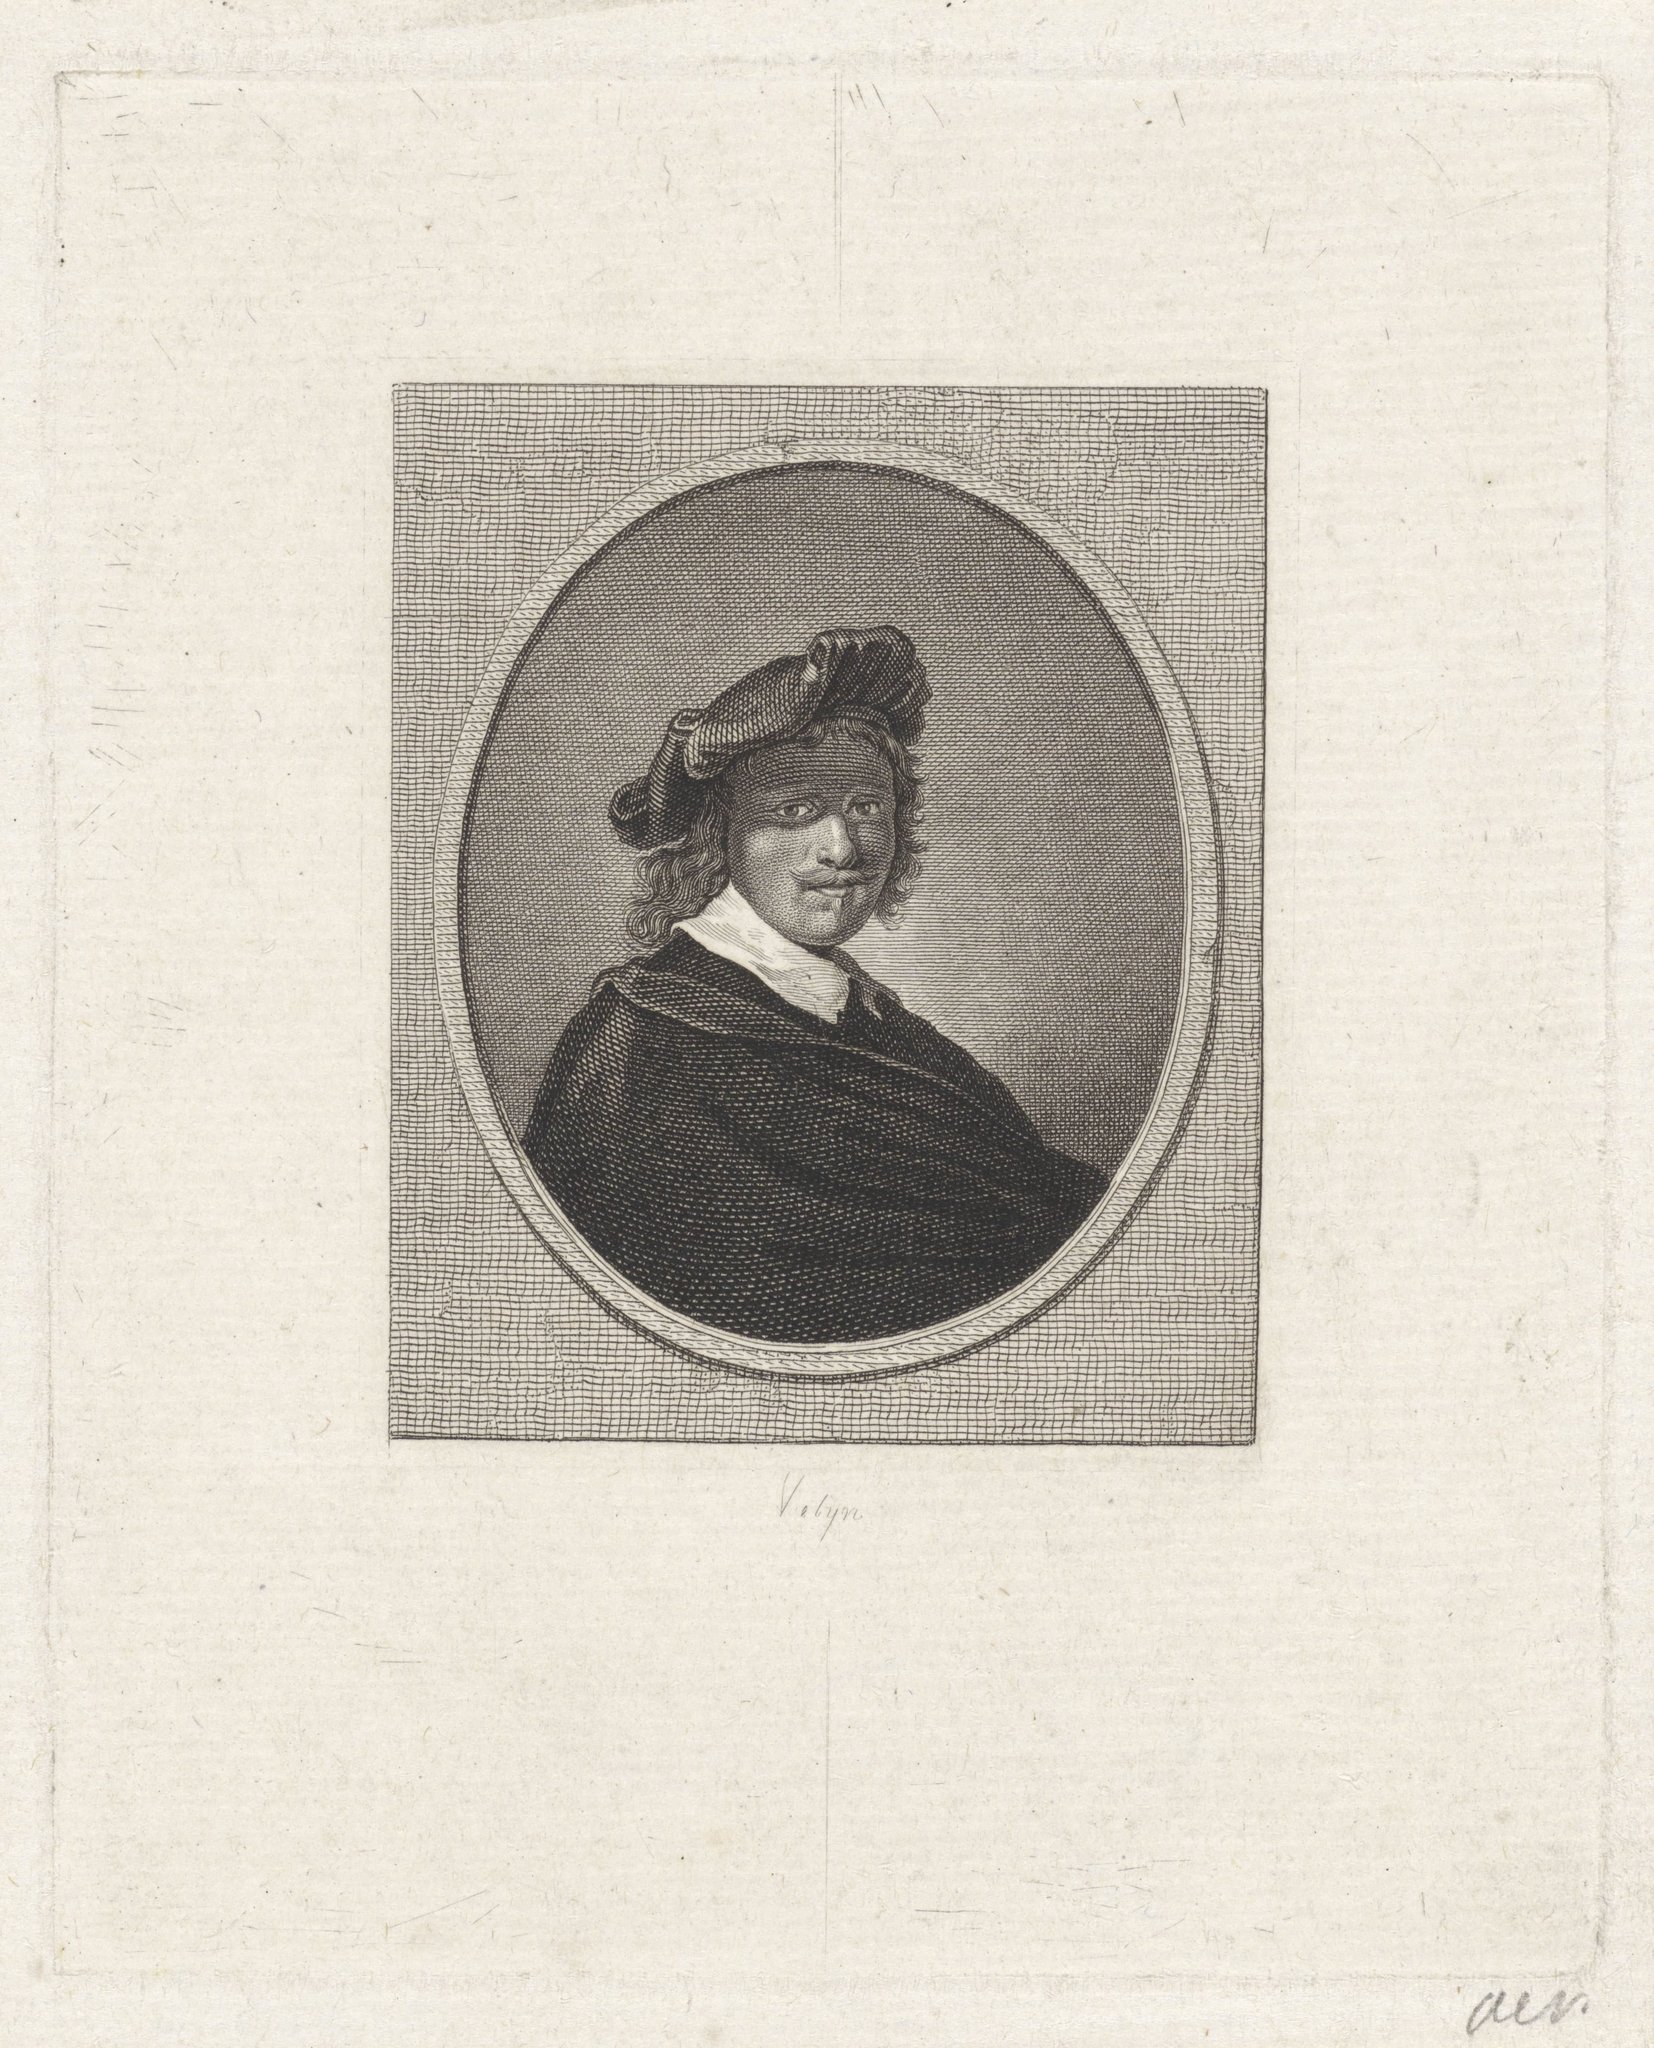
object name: print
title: Portret van Gerard Dou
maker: philippus velijn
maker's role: print maker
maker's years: 1787-1836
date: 1827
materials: paper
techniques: engraving, etching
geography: netherlands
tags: draughtsman, gerard dou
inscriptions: collector's mark: Lugt 2228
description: Een latere staat van deze prent ook gebruikt in: Almanak voor het schoone en goede voor 1827, Amsterdam (G.J.A. Beijerinck) 1827